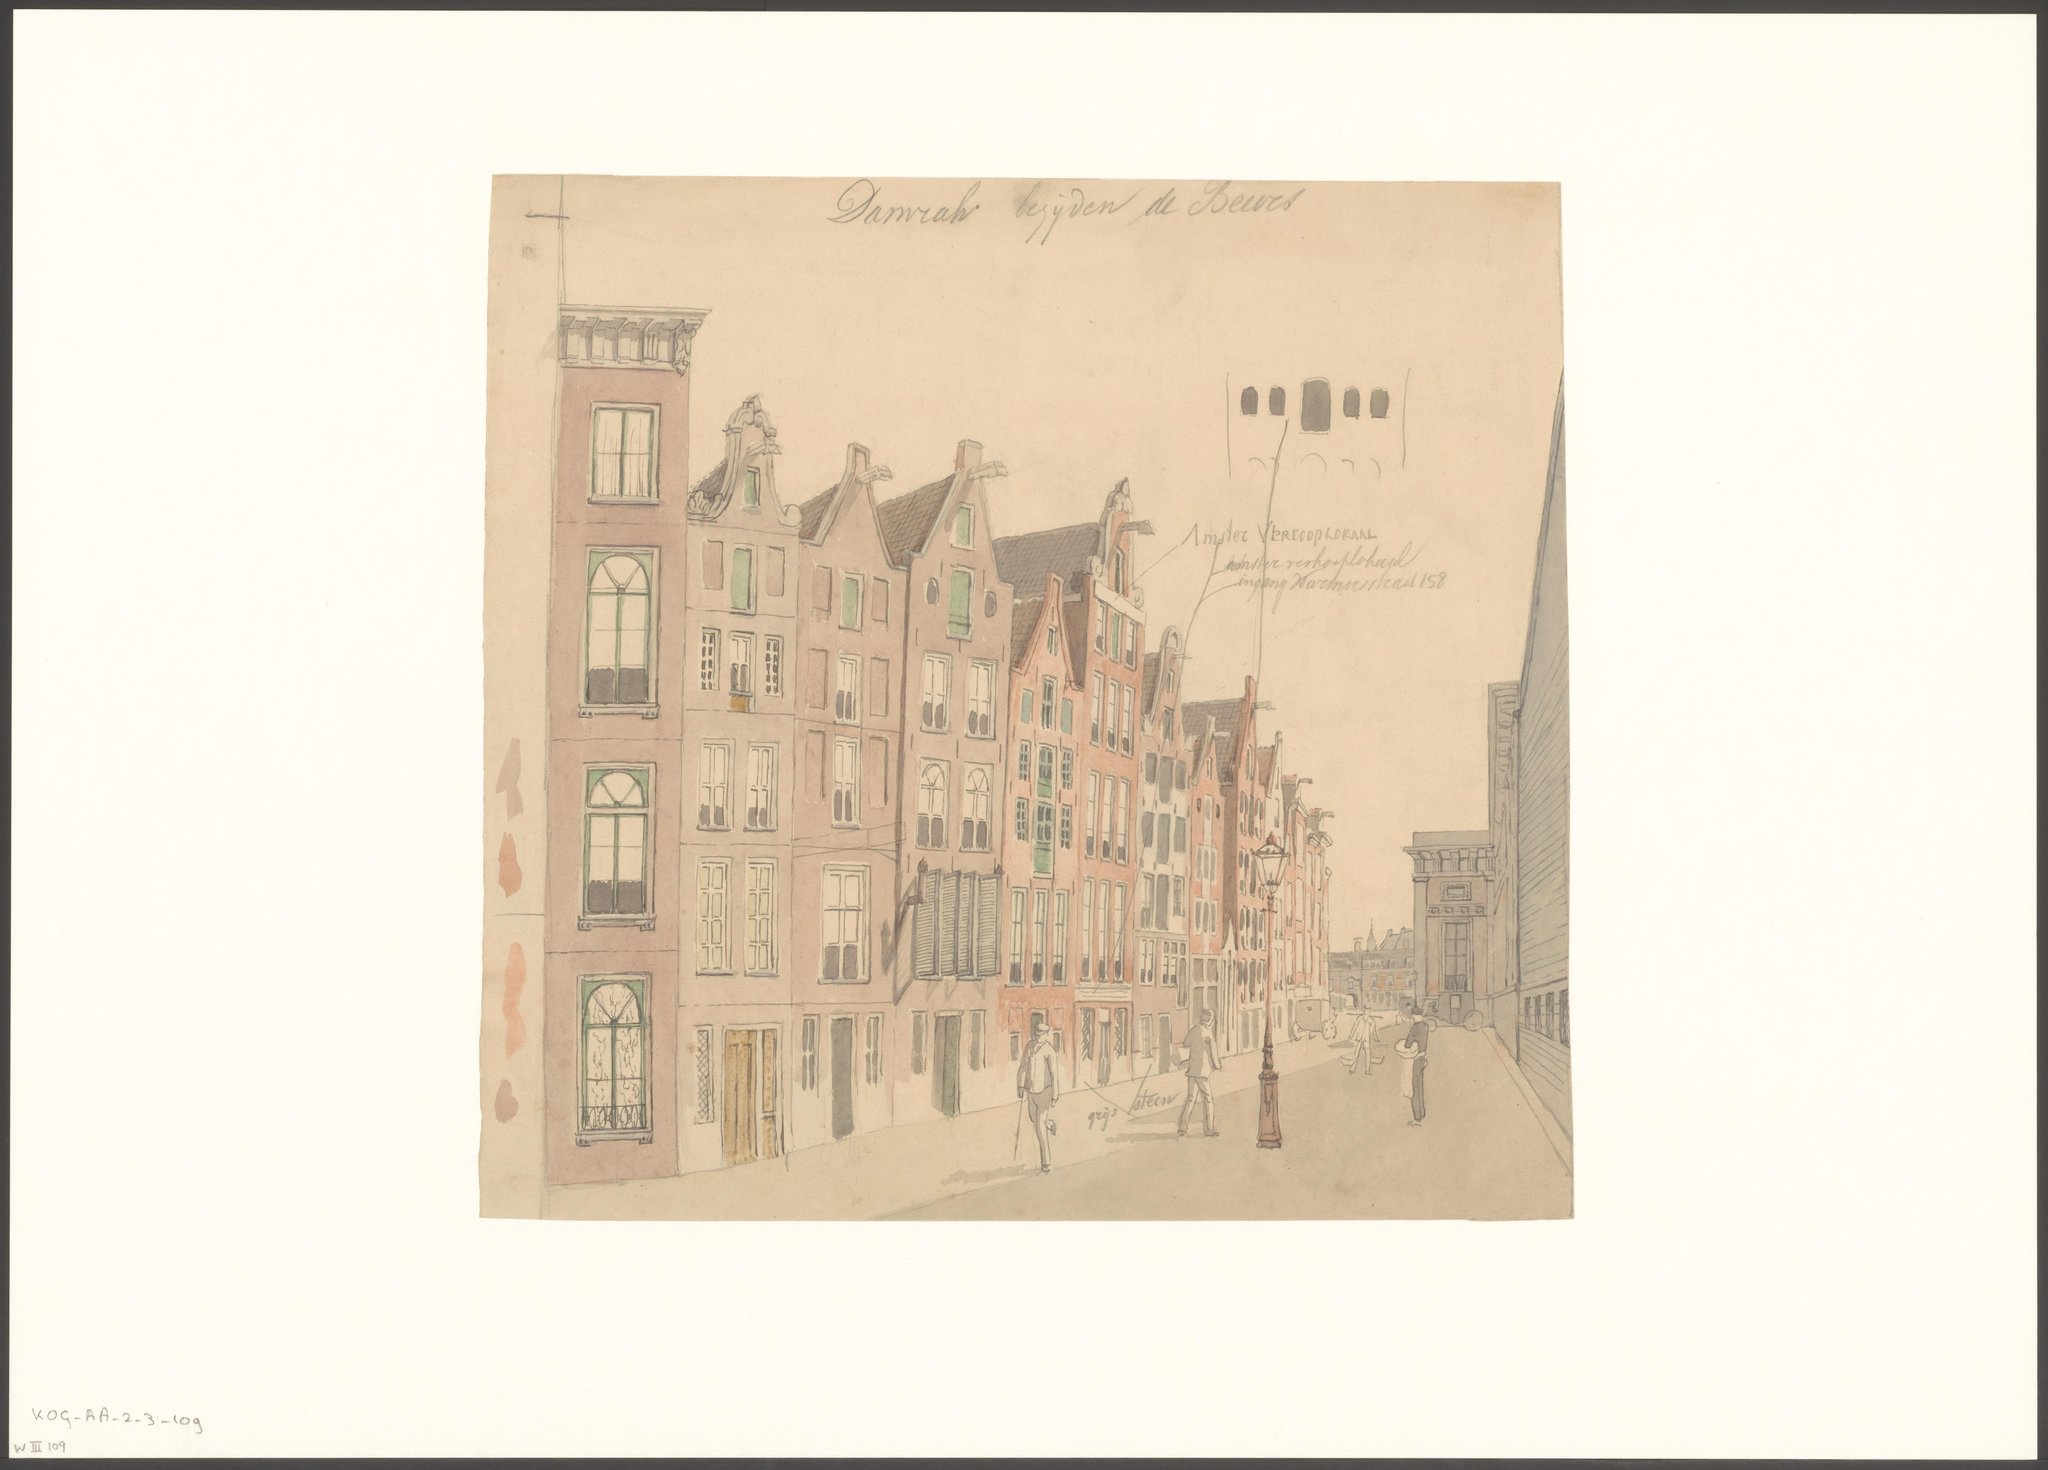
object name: drawing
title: Gezicht op de Damrak naast de Beurs van Zocher, gezien naar de Vijgendam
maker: johan martinus anthon rieke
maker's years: 1851-1899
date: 1861-1899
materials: ink, paper, pencil, watercolor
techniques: brush, pen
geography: amsterdam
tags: city-view in general; 'veduta', façade (of house or building), street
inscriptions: inscription: ‘Damrak bezijden de (...) 158 / grijs steen’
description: Tekening binnen de Atlas Van Eck ingedeeld op wijknummer 3.